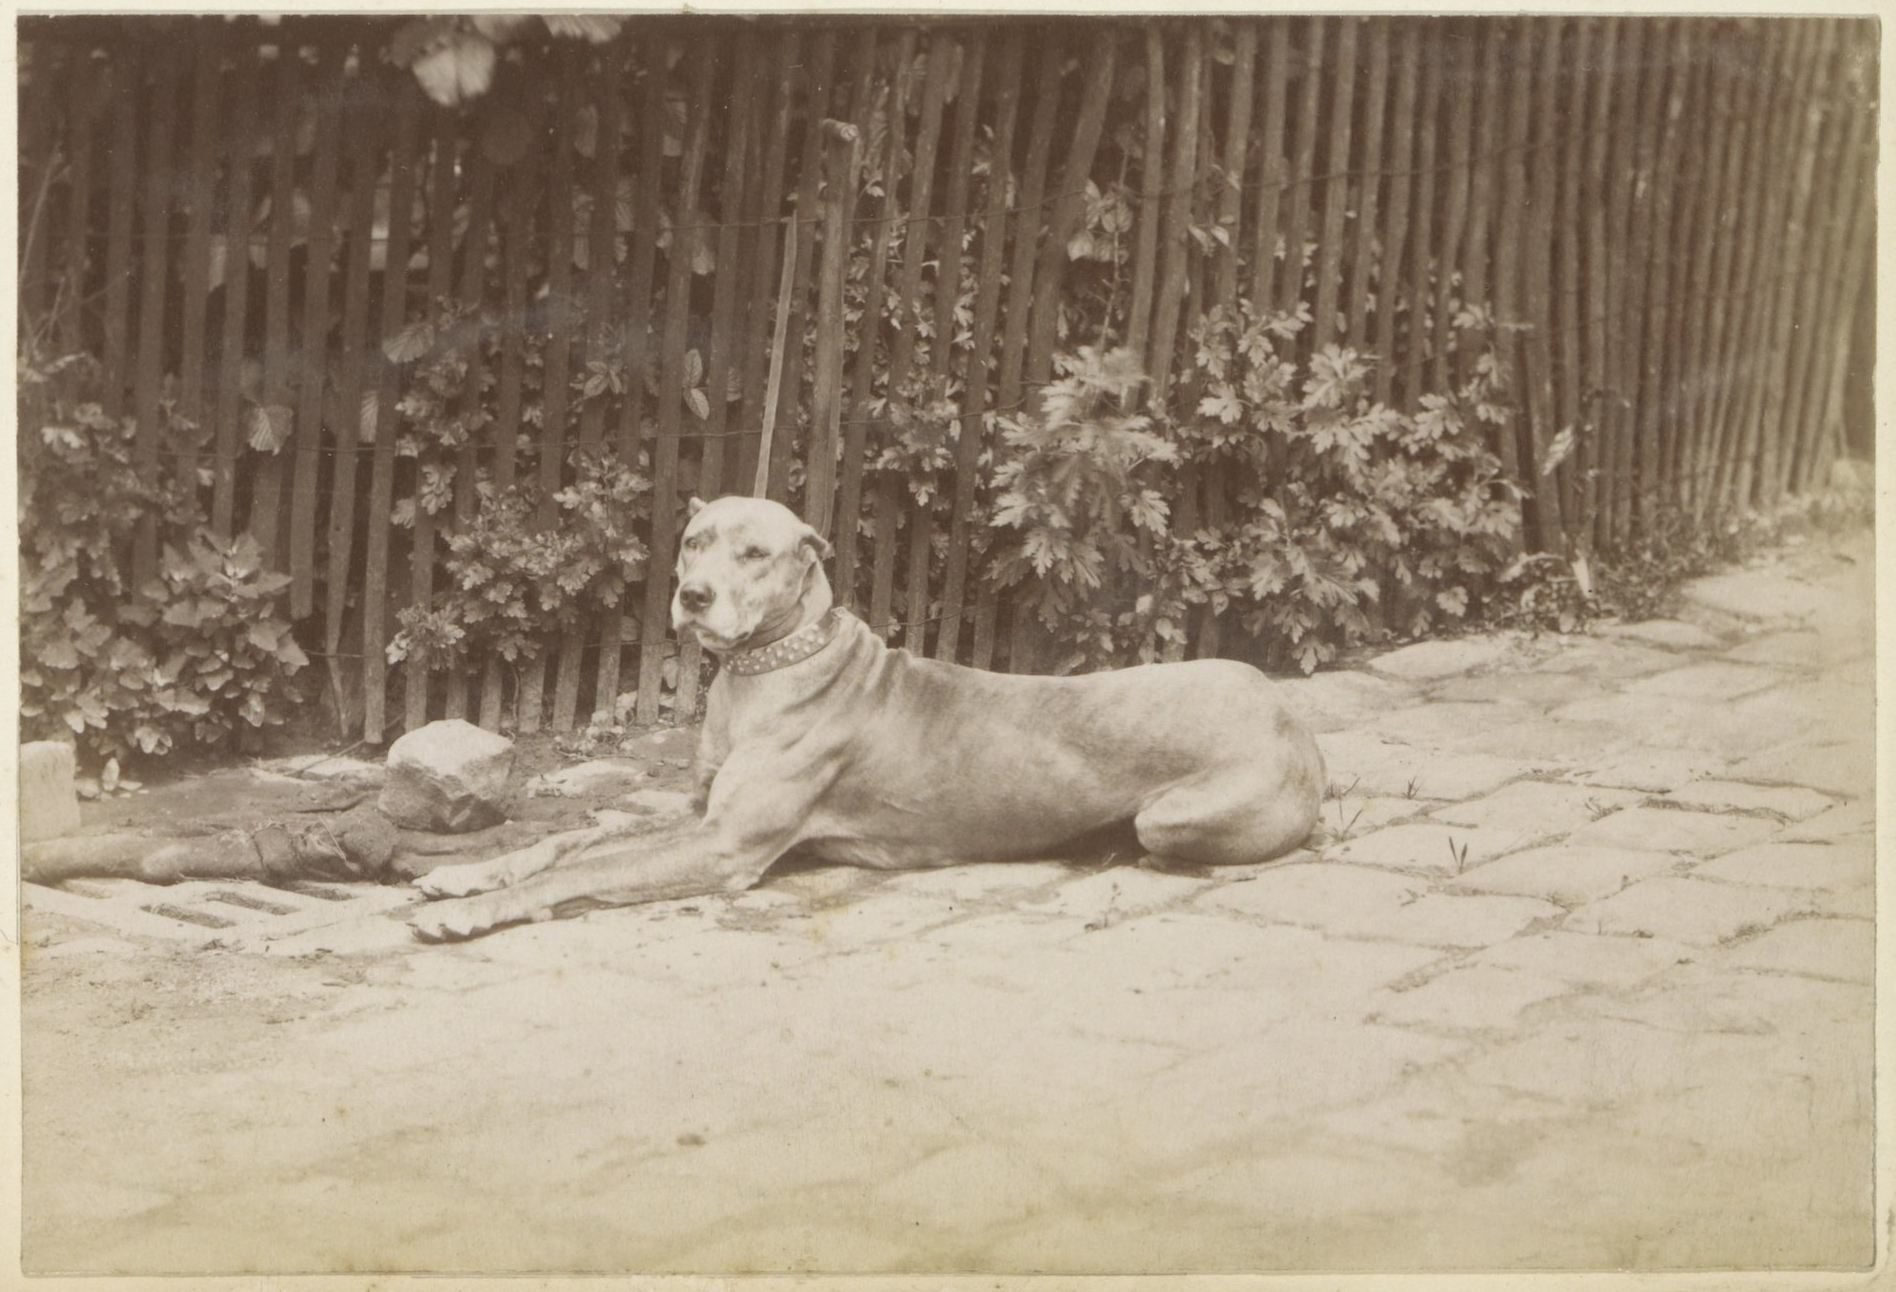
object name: photograph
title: Aangelijnde hond liggend bij een hek in Frankrijk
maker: Anonymous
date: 1900-1910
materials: paper, photographic support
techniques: albumen print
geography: france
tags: fence, wall, paling, dog, france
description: Onderdeel van Fotoalbum van een Franse amateurfotograaf met opnames van een familie, distilleerderij Delizy & Doistau Fils, het leger en bezienswaardigheden in Frankrijk.